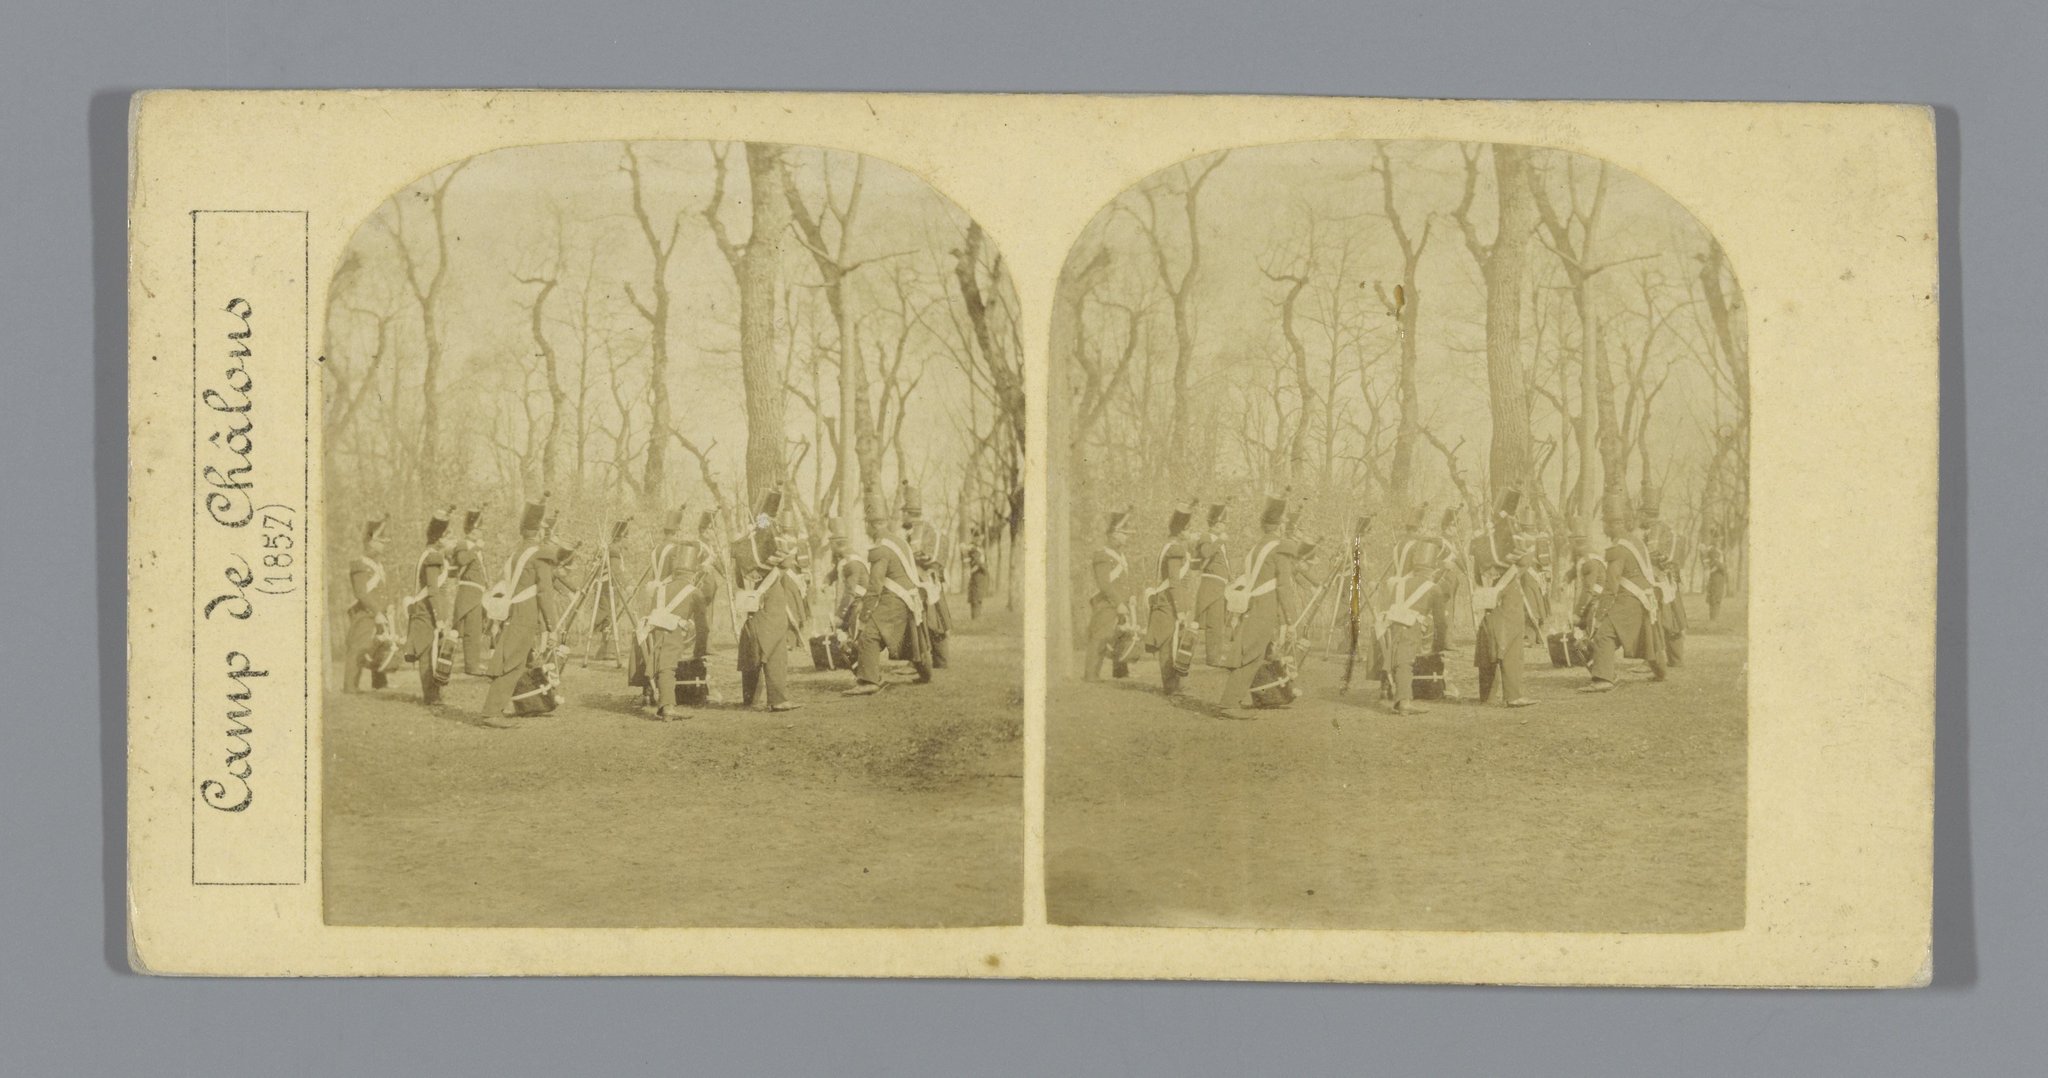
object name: stereograph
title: Camp de Châlons 1857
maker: Anonymous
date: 1857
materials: cardboard, photographic support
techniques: albumen print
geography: mourmelon-le-grand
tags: private soldier, the soldier; the soldier's life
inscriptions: number: ‘N 1063’, number: ‘No. 2’